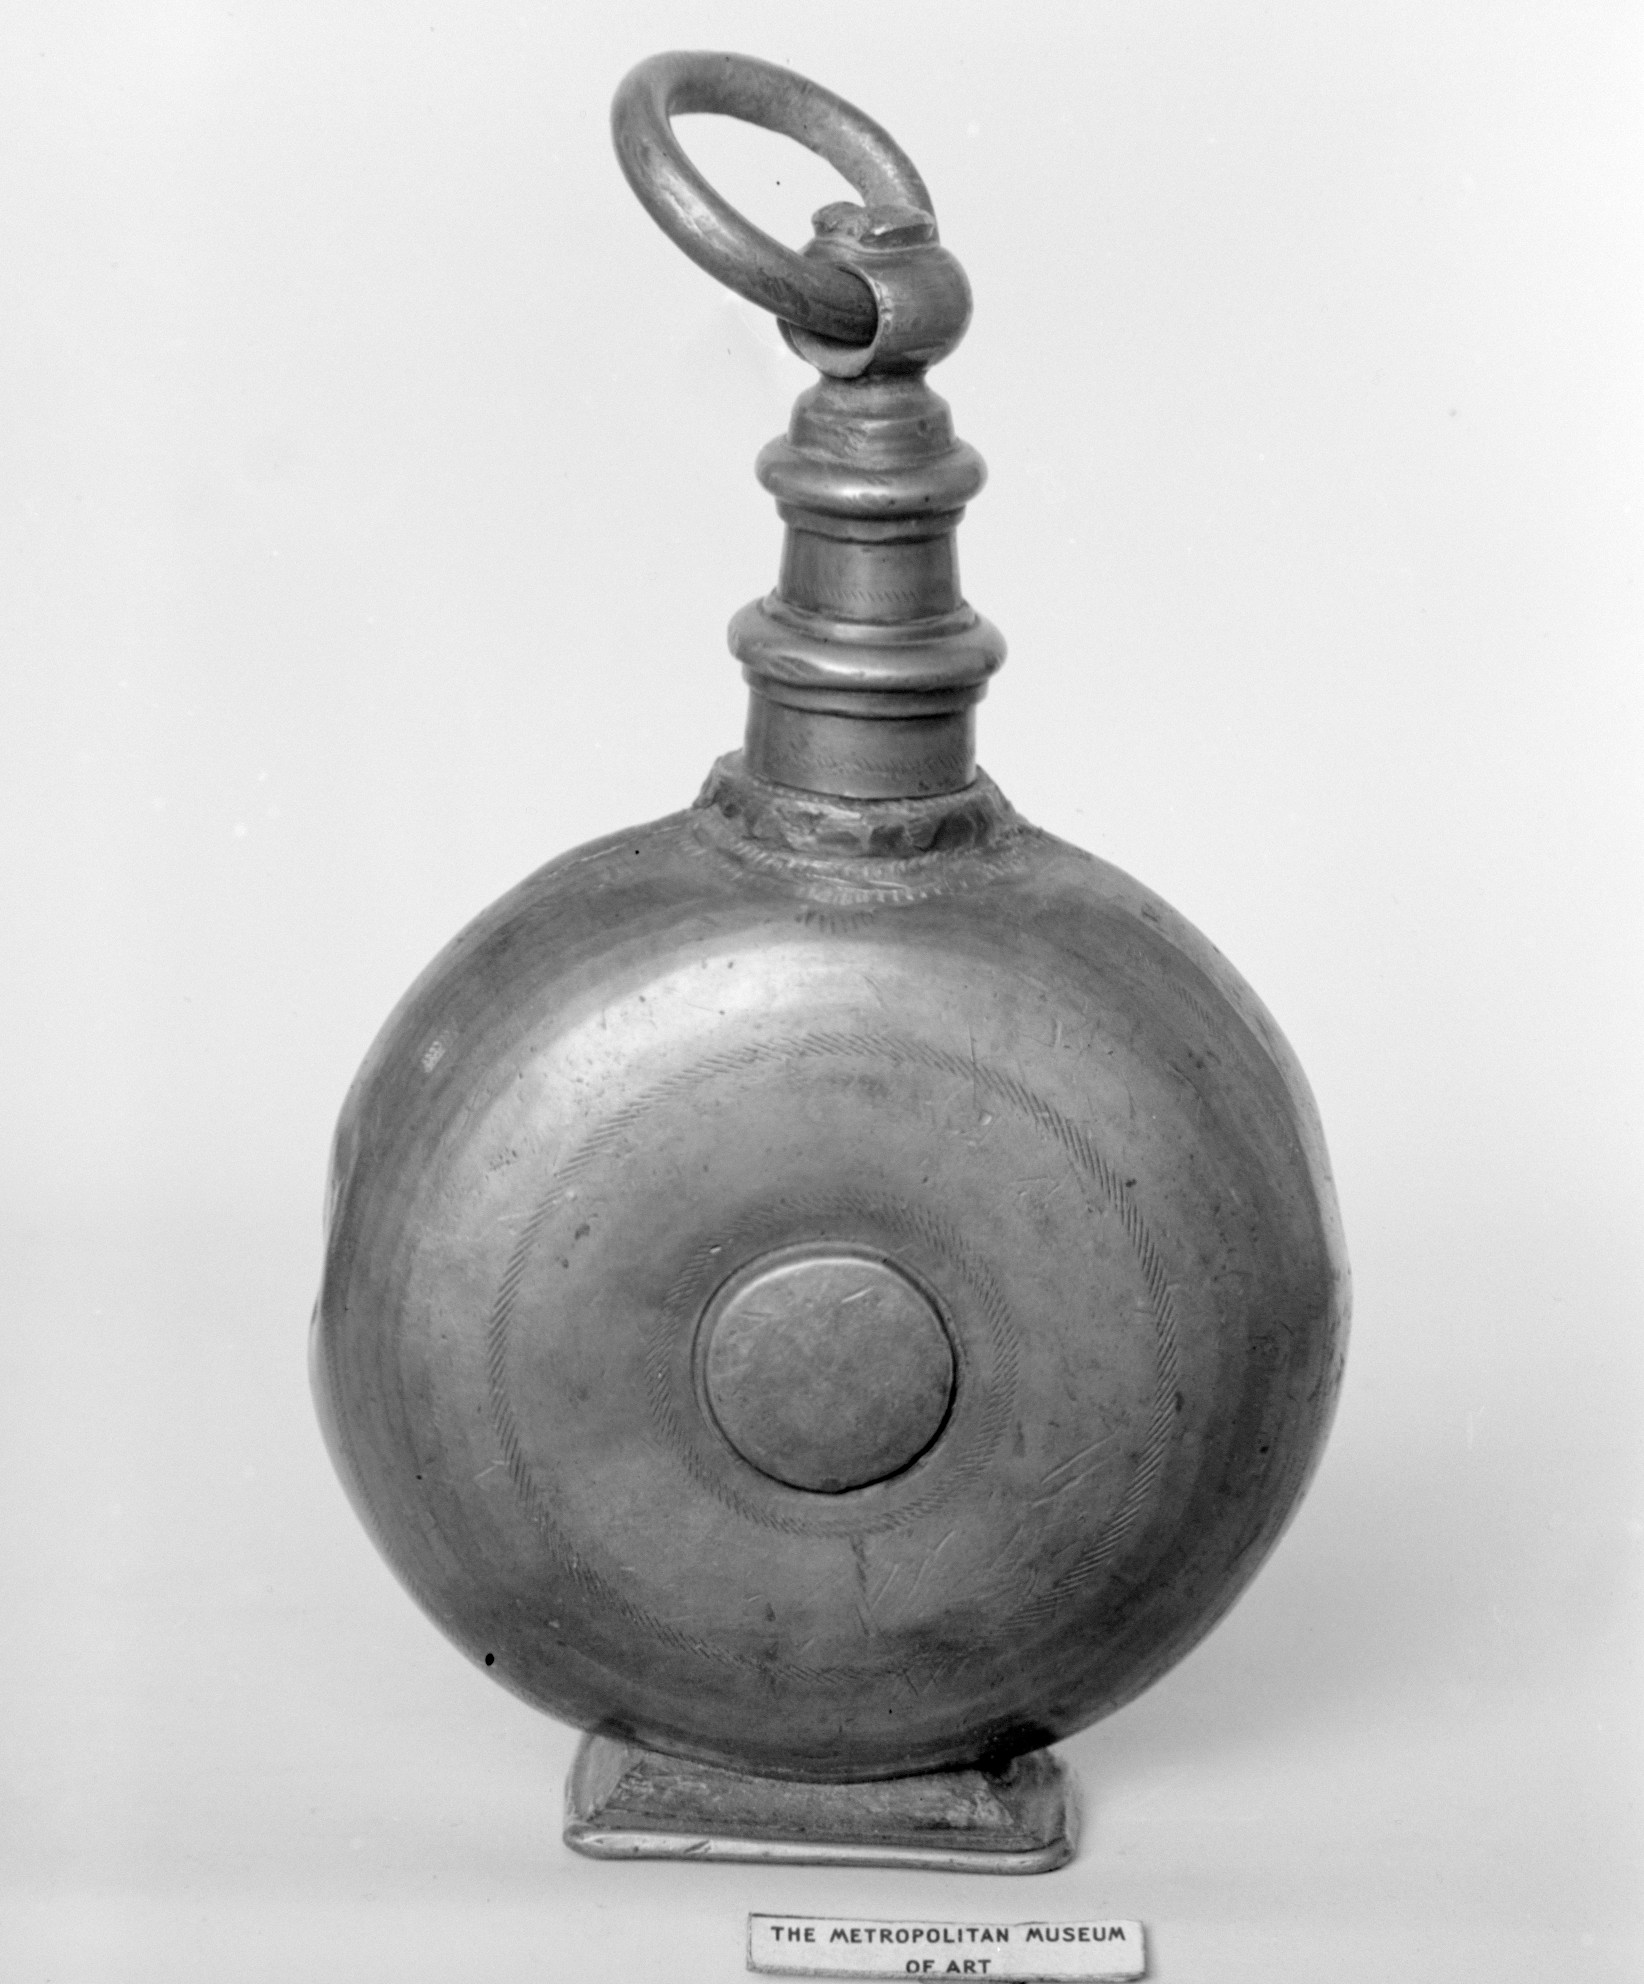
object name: bottle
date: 1601-1800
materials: pewter